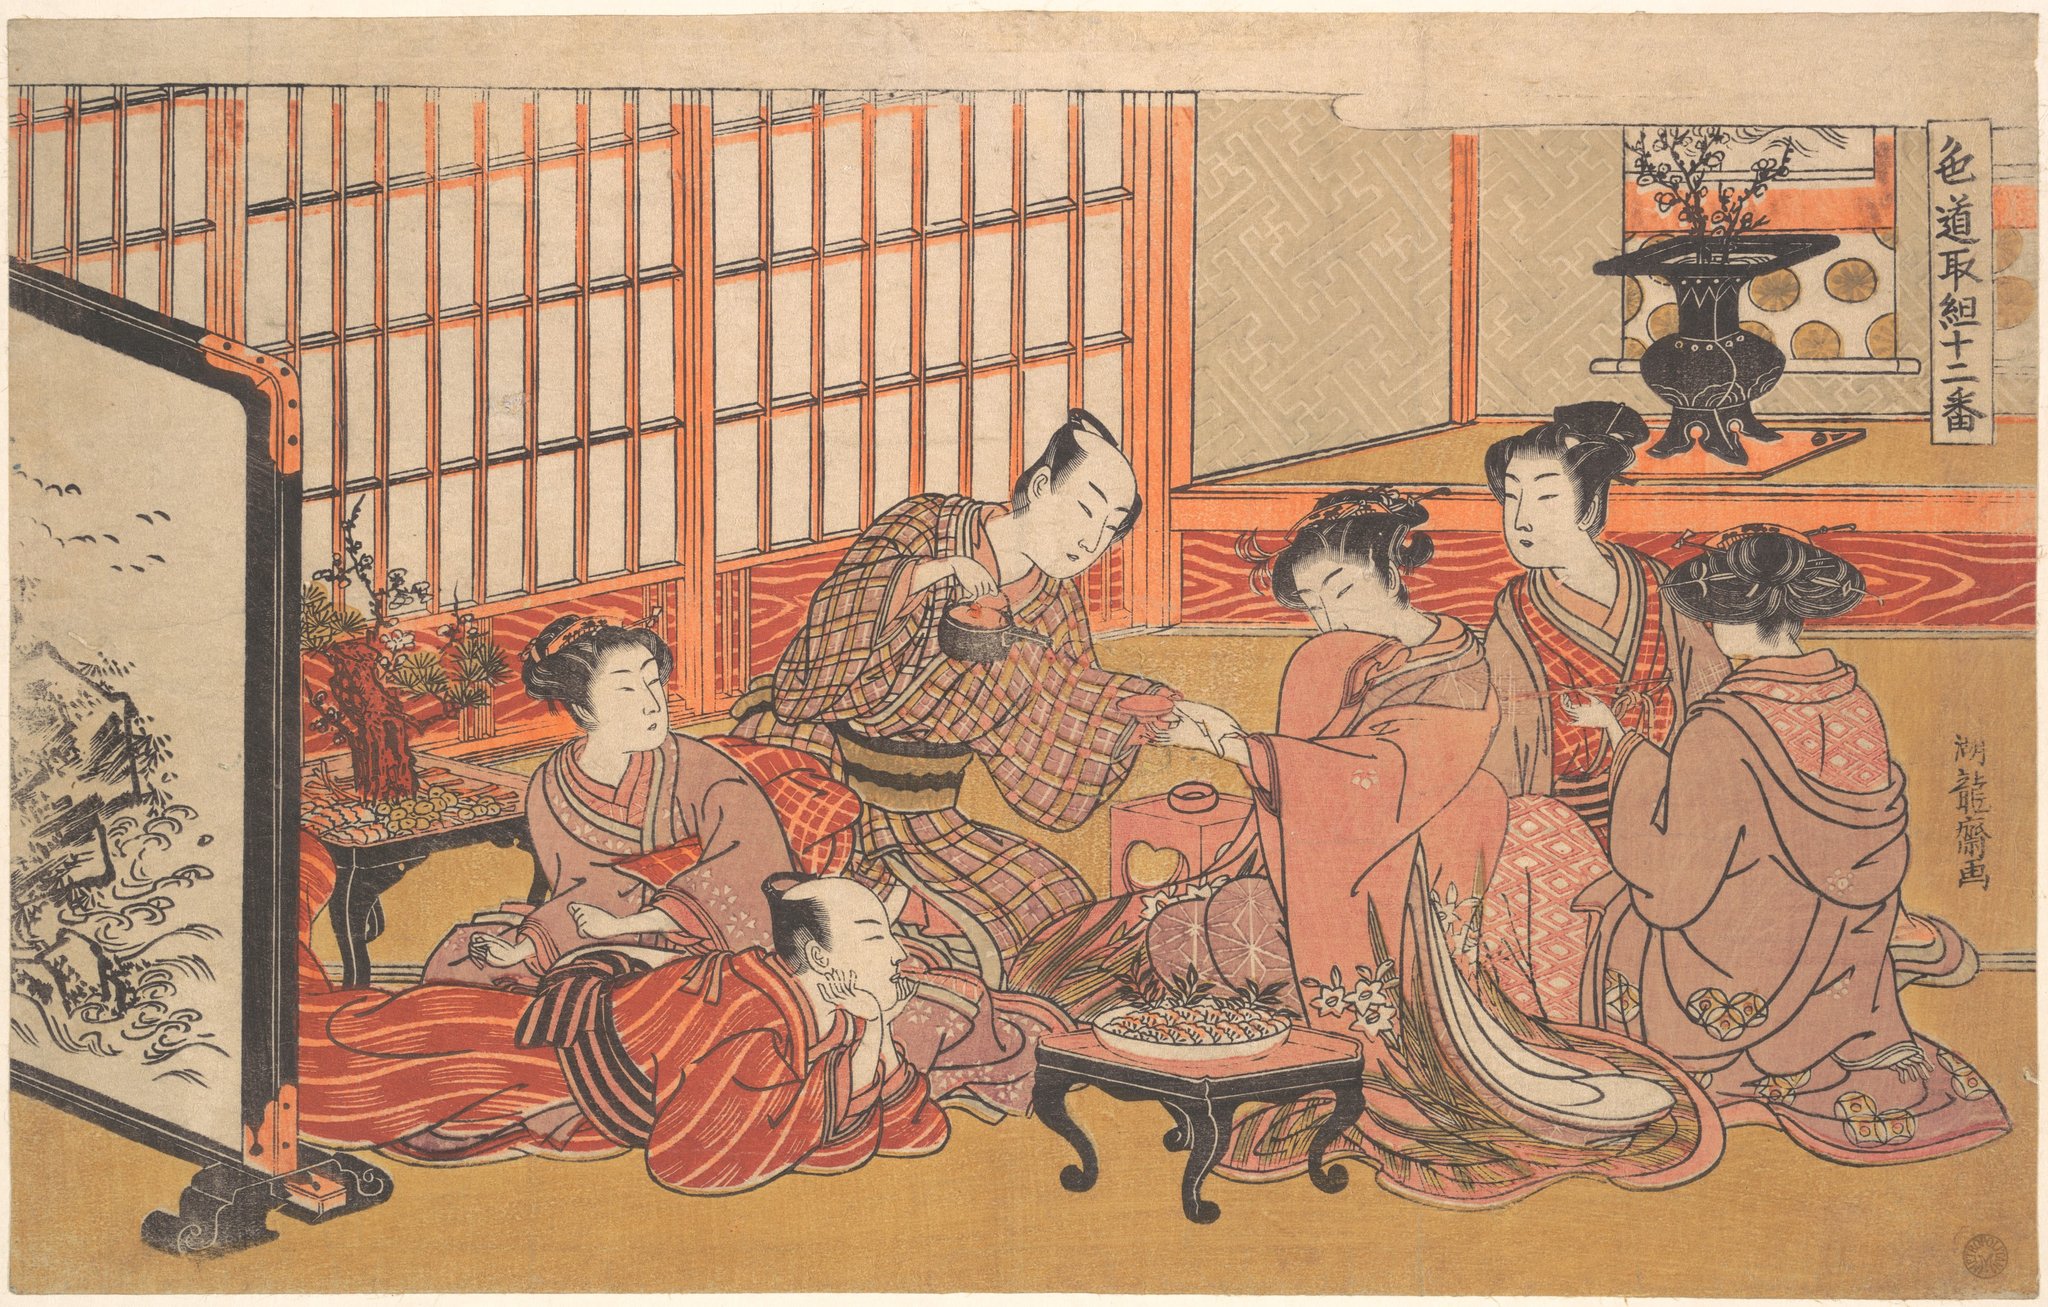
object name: print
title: A Mock Marriage Ceremony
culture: japanese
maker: isoda koryūsai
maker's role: artist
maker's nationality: japanese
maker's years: 1735-1790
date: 1773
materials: ink, paper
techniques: woodblock print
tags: men,women